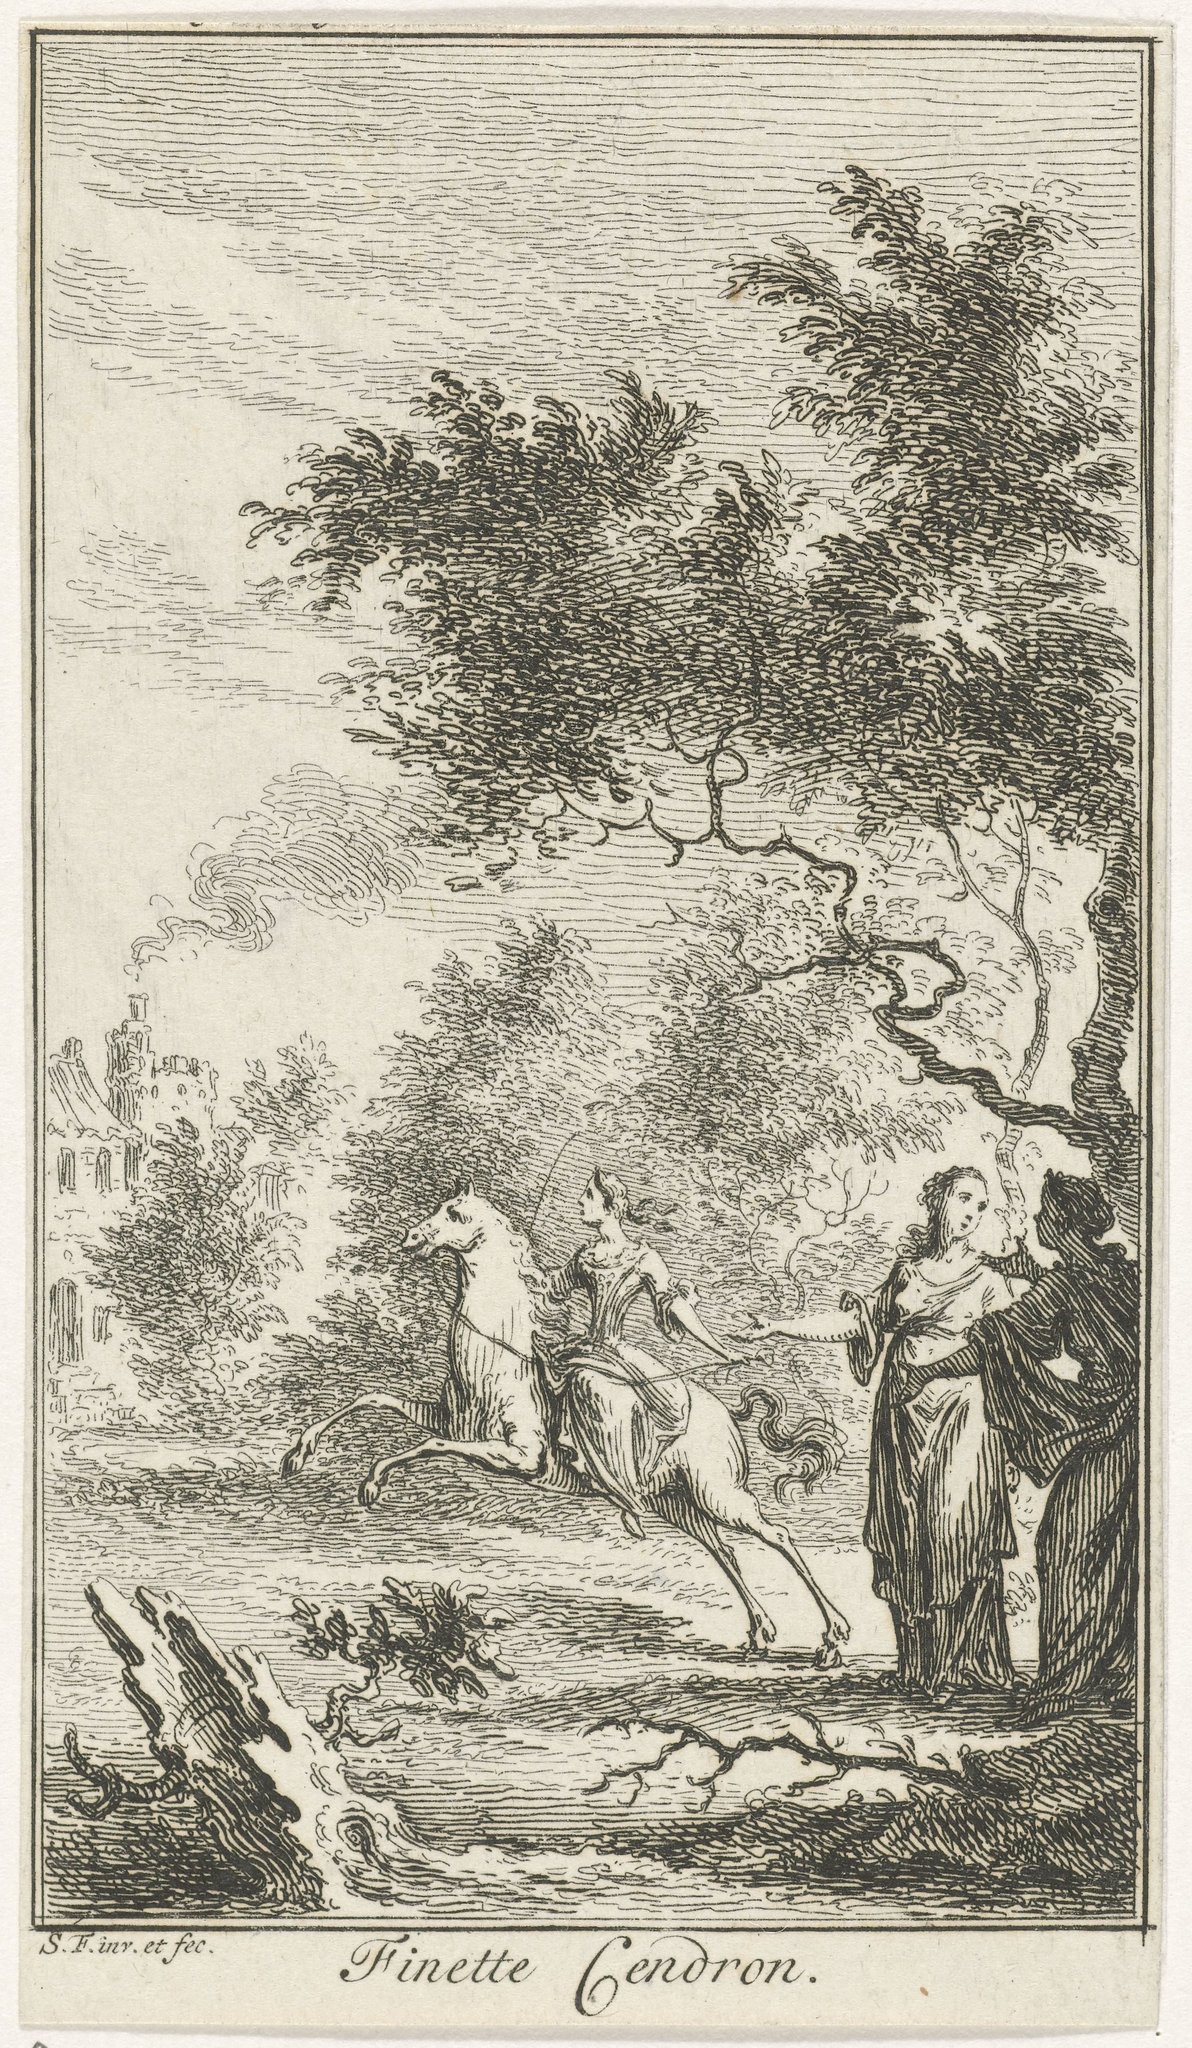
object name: print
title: Finette Cendron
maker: simon fokke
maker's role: draughtsman, print maker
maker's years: 1712-1784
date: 1722-1784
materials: paper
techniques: etching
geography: amsterdam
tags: riding a horse, ass, or mule; rider, horseman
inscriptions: collector's mark: Lugt 240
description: Prent mogelijk vervaardigd om een uitgave van de verhalen van Marie-Catherine Le Jumel de Barneville, comtesse d’Aulnoy te illustreren.